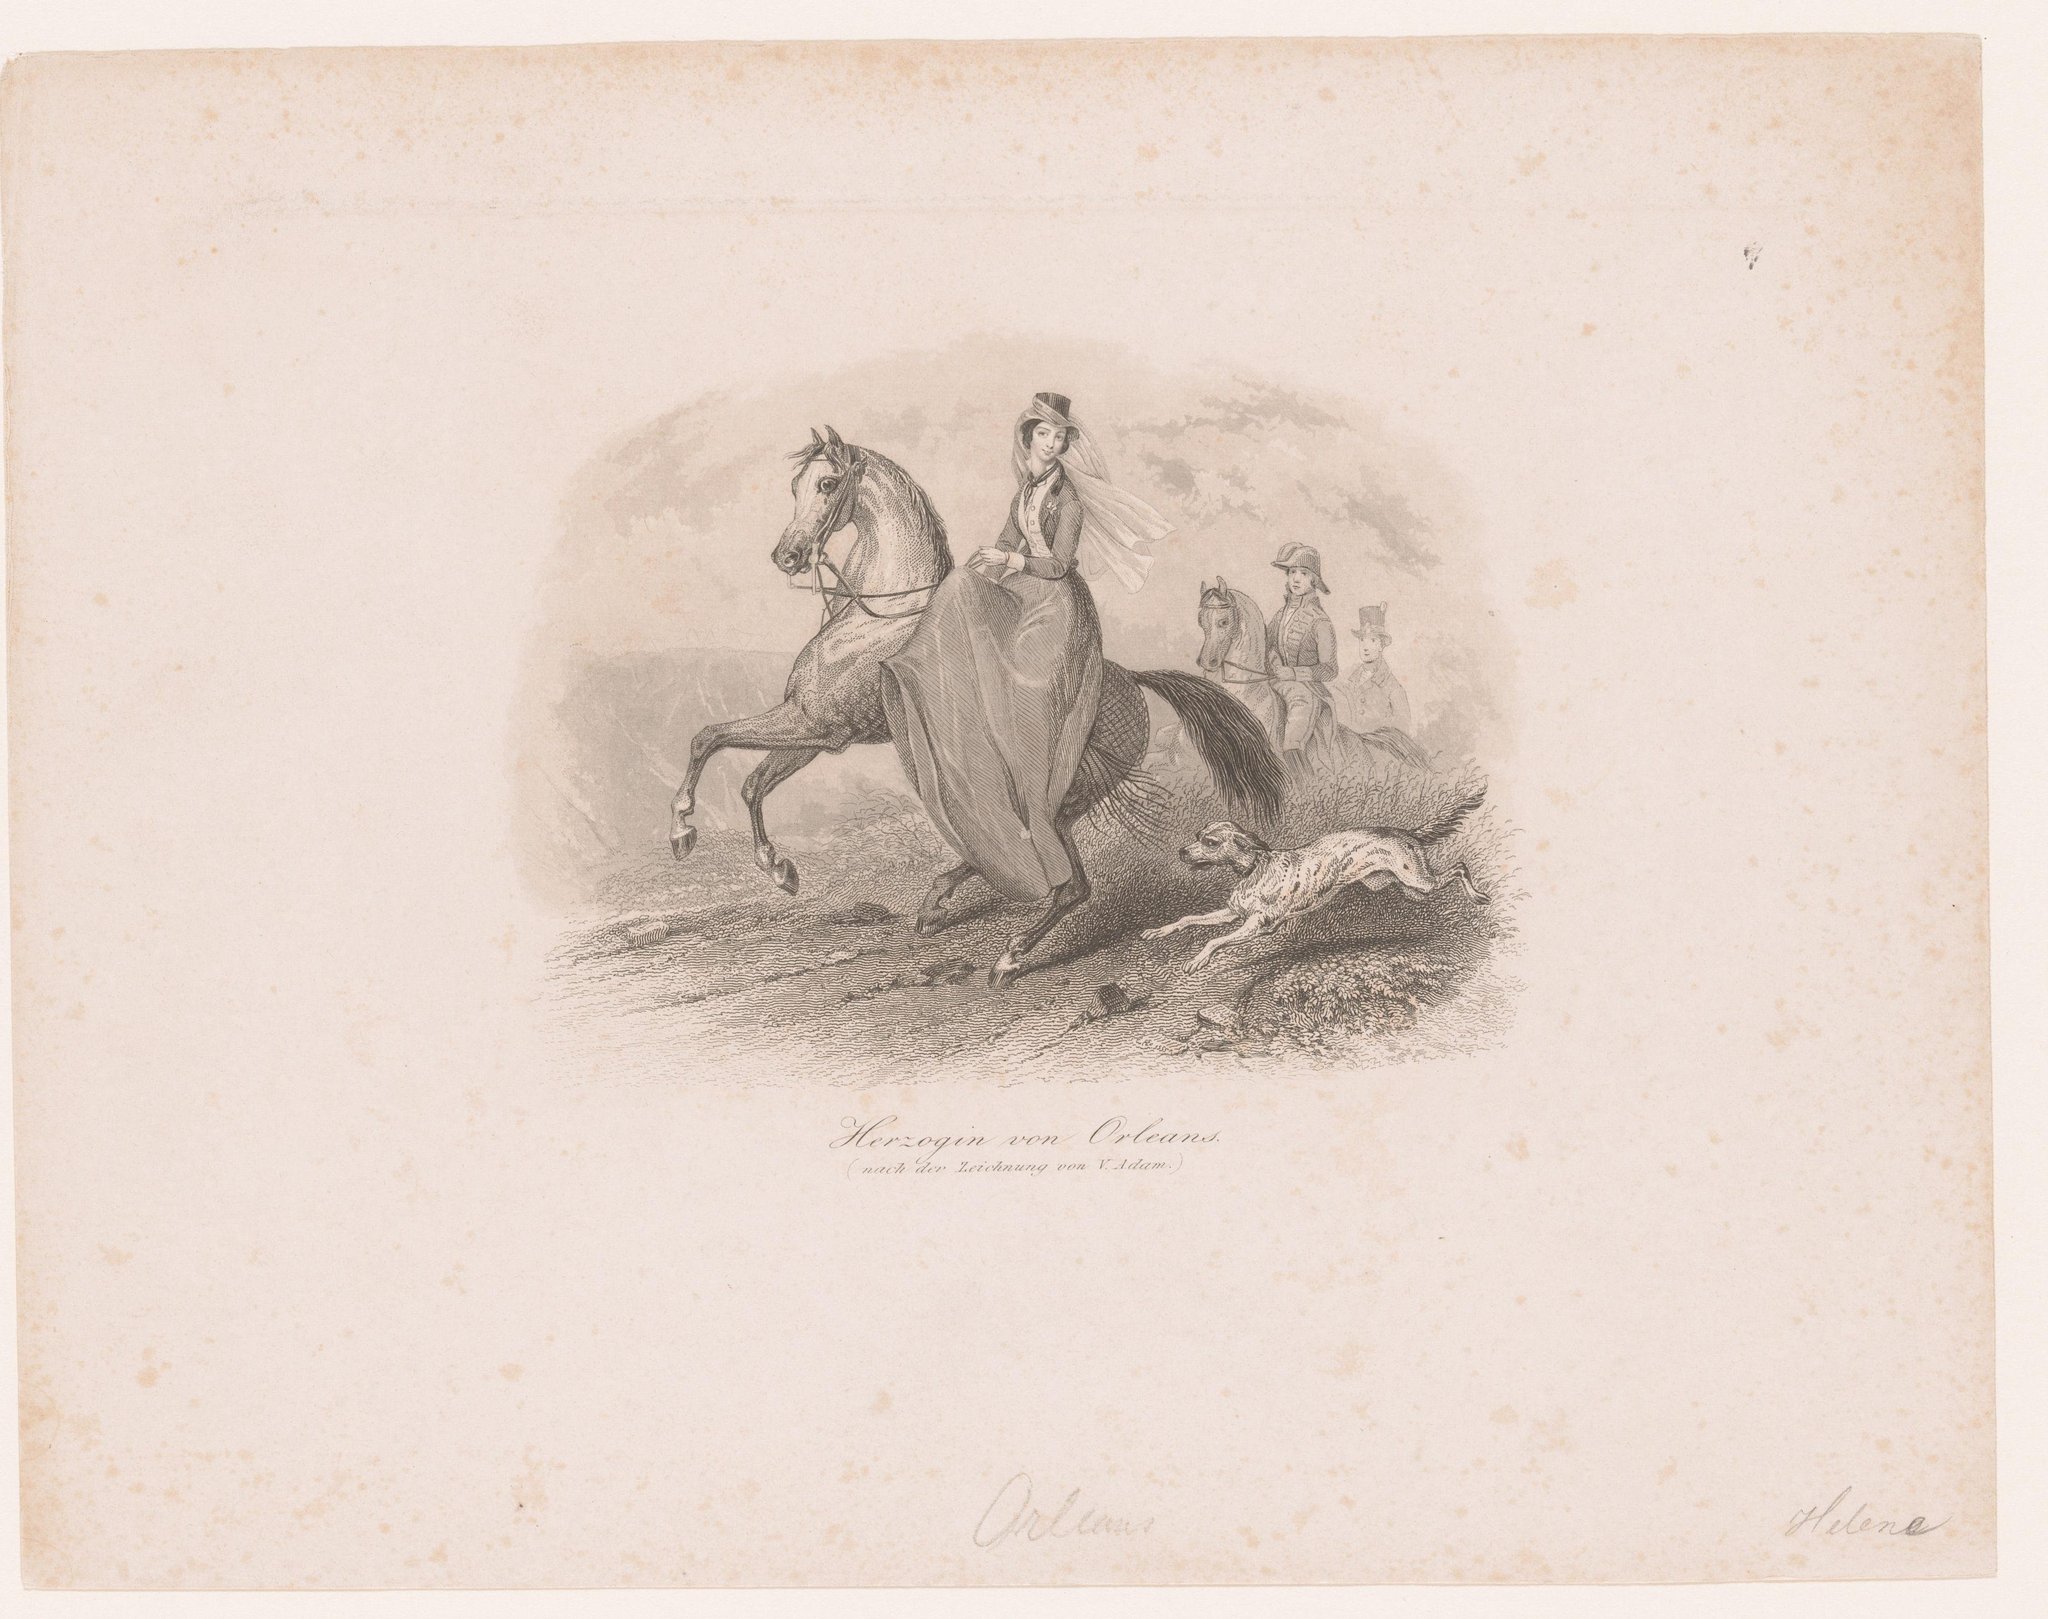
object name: print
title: Portret van Helene van Mecklenburg-Schwerin te paard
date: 1811-1866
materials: paper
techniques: engraving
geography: germany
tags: helene van mecklenburg-schwerin, equestrian state-portrait, historical persons - bb - woman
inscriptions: collector's mark: Lugt 2228